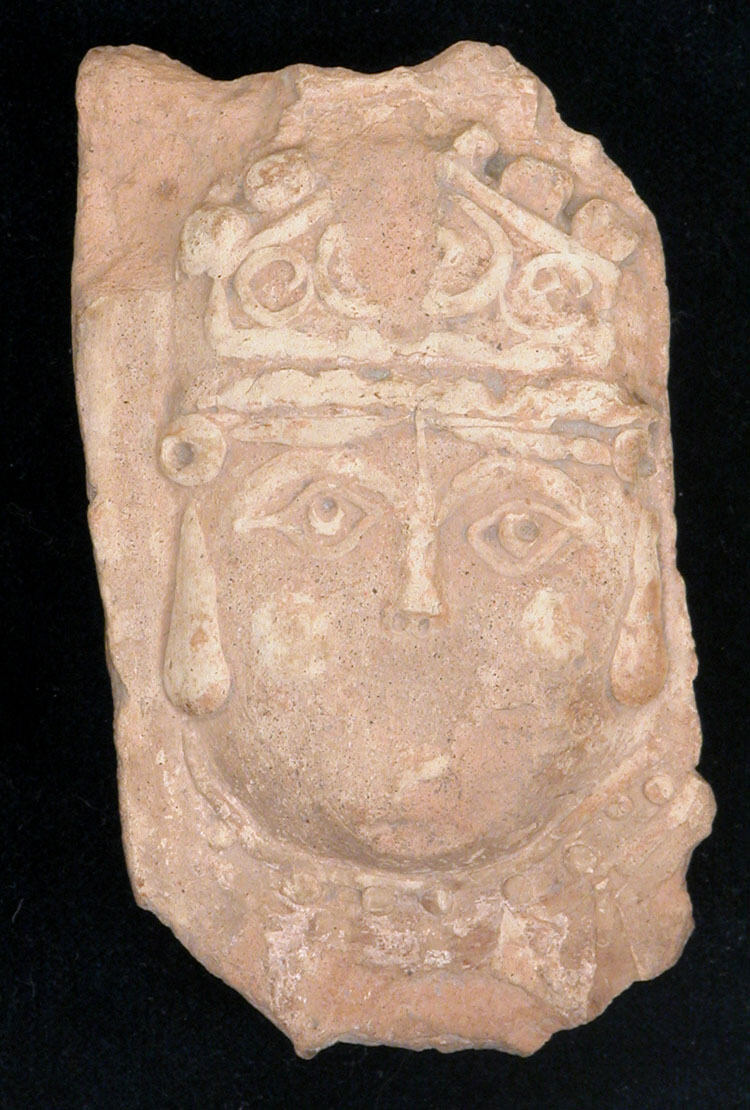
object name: fragment of a jar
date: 1101-1200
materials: earthenware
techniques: molding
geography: iraq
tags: faces